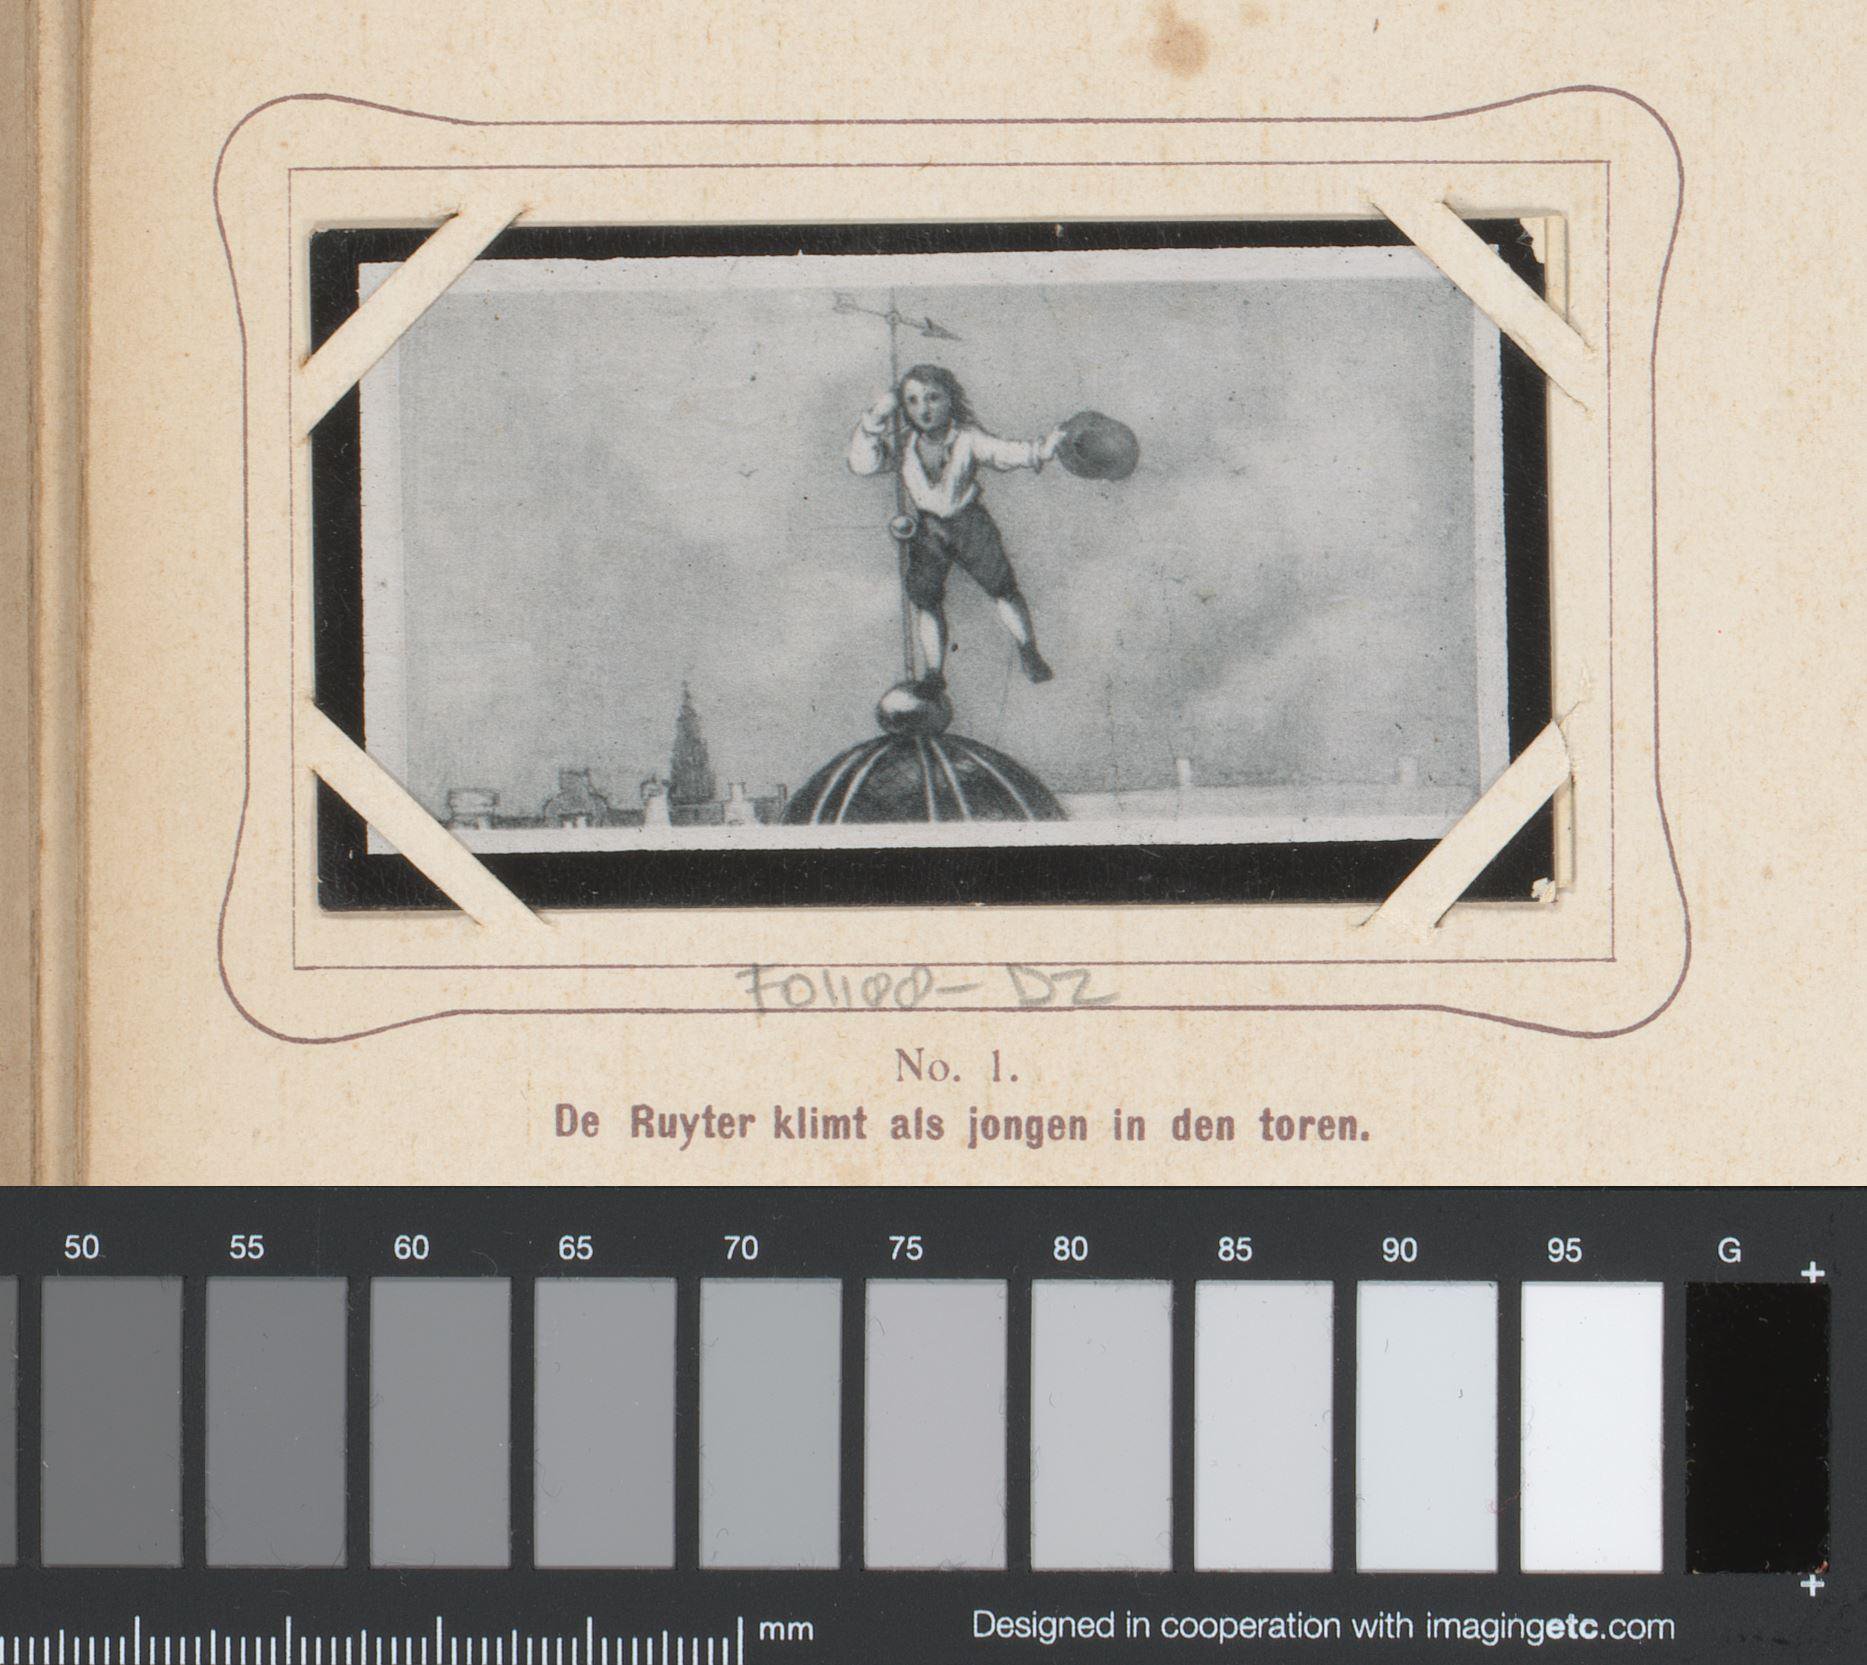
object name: reproduction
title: Reproductie van een tekening van een jonge Michiel Adriaenszoon de Ruyter in een toren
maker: Anonymous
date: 1906-1907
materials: paper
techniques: photograph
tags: flushing, michiel adriaenszoon de ruyter, tower, clock tower ~ monumental adornment, historical persons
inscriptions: inscription: ‘No. 1./ De Ruyter klimt als jongen in den toren.’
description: Deze prent maakt deel uit van een album.